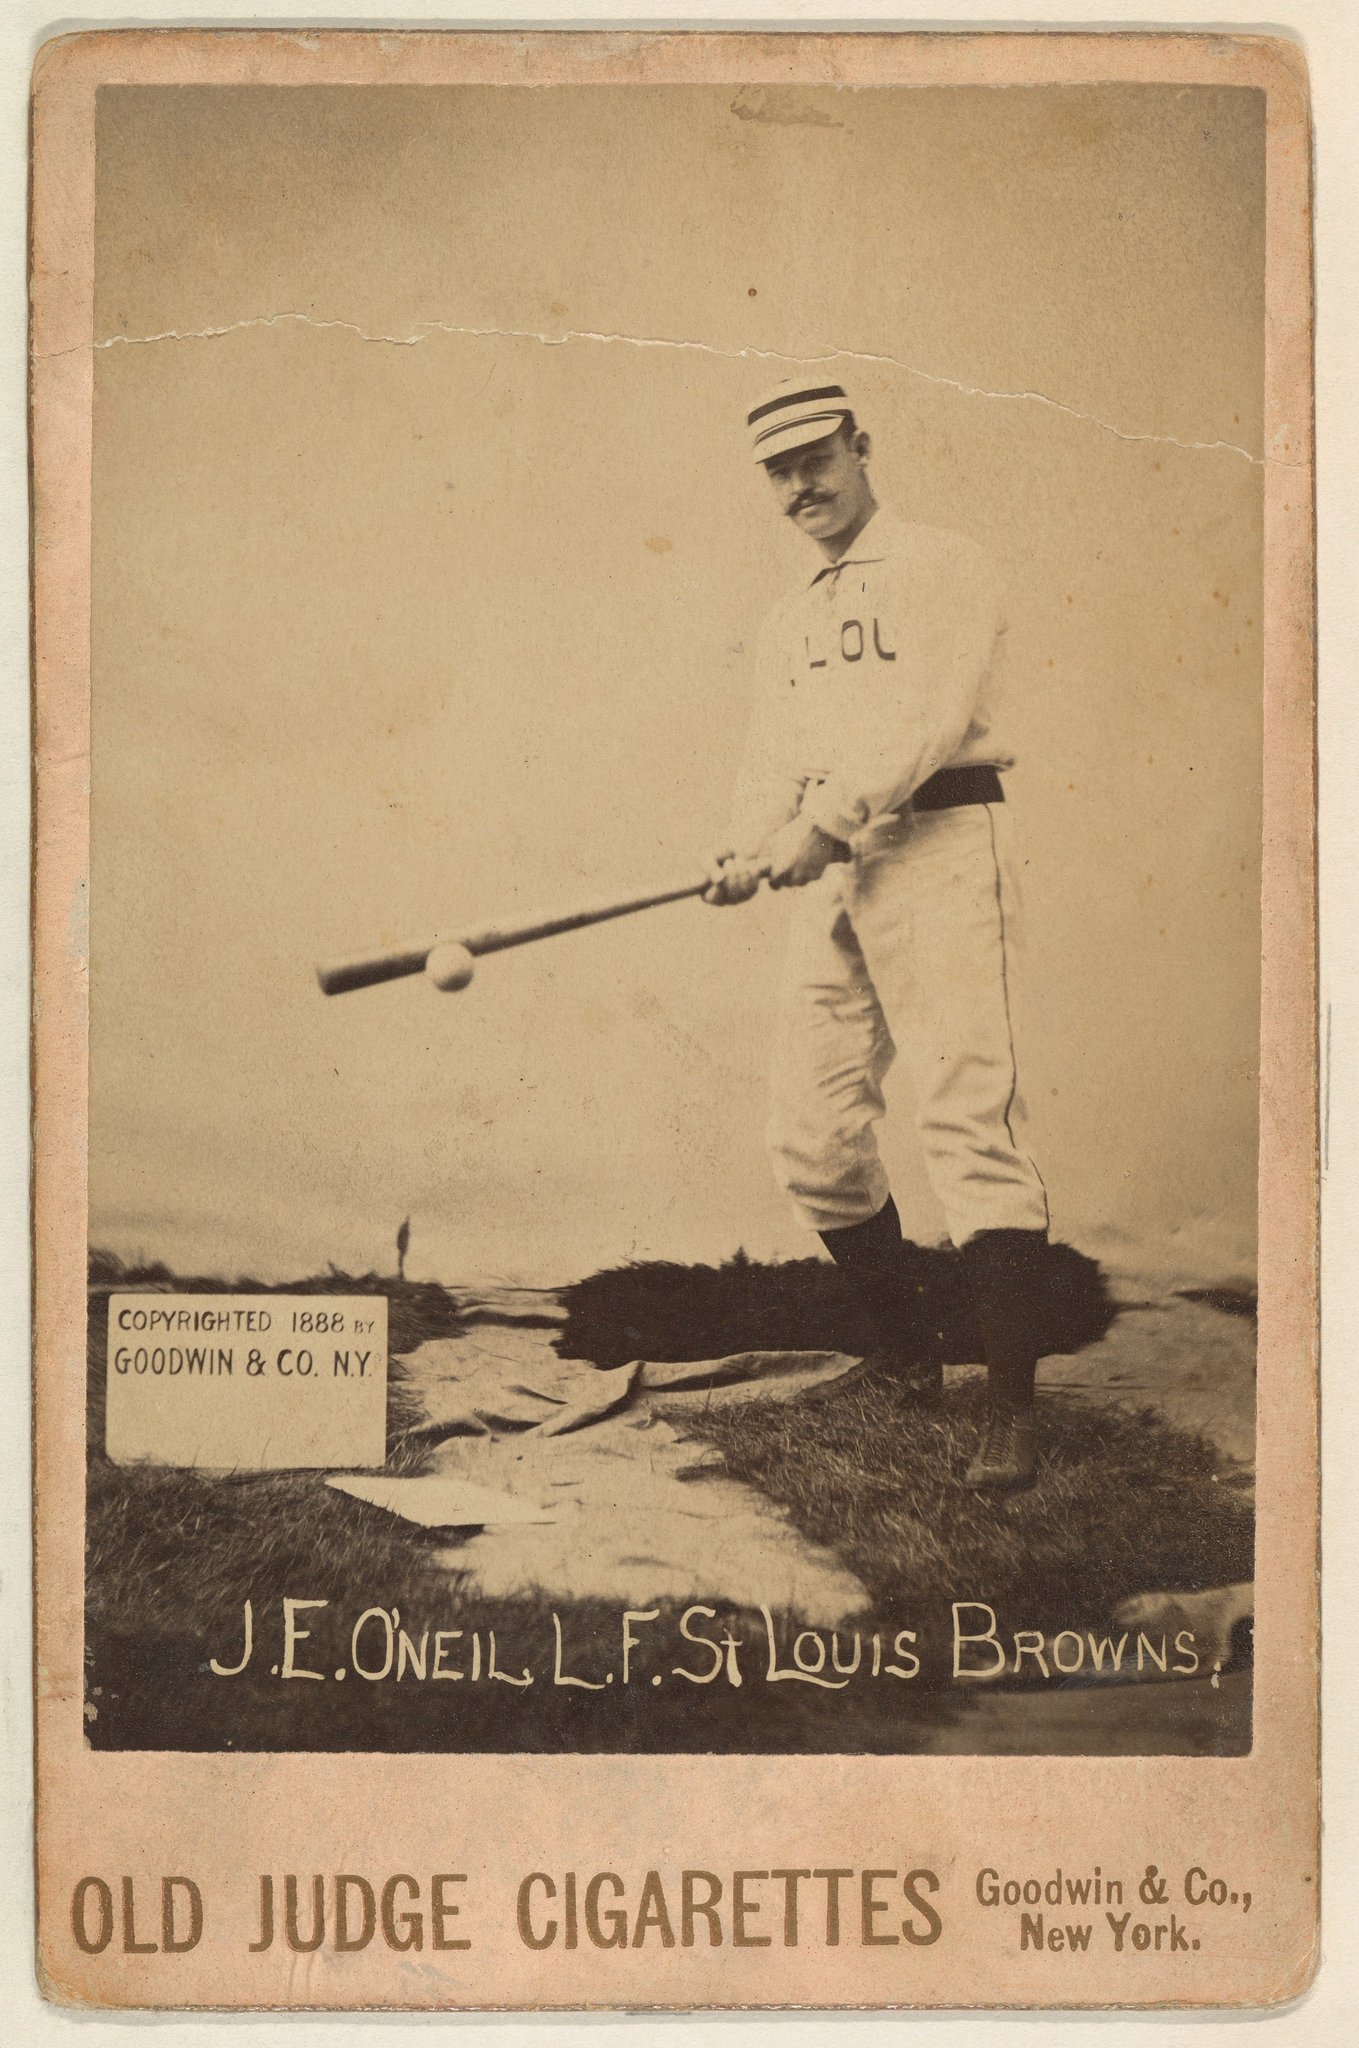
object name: baseball card, photograph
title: J.E. O'Neil, Left Field, St. Louis Browns, from the series Old Judge Cigarettes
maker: goodwin & company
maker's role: publisher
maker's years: 1850-1950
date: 1888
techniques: albumen print, photography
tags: men,portraits,baseball,athletes